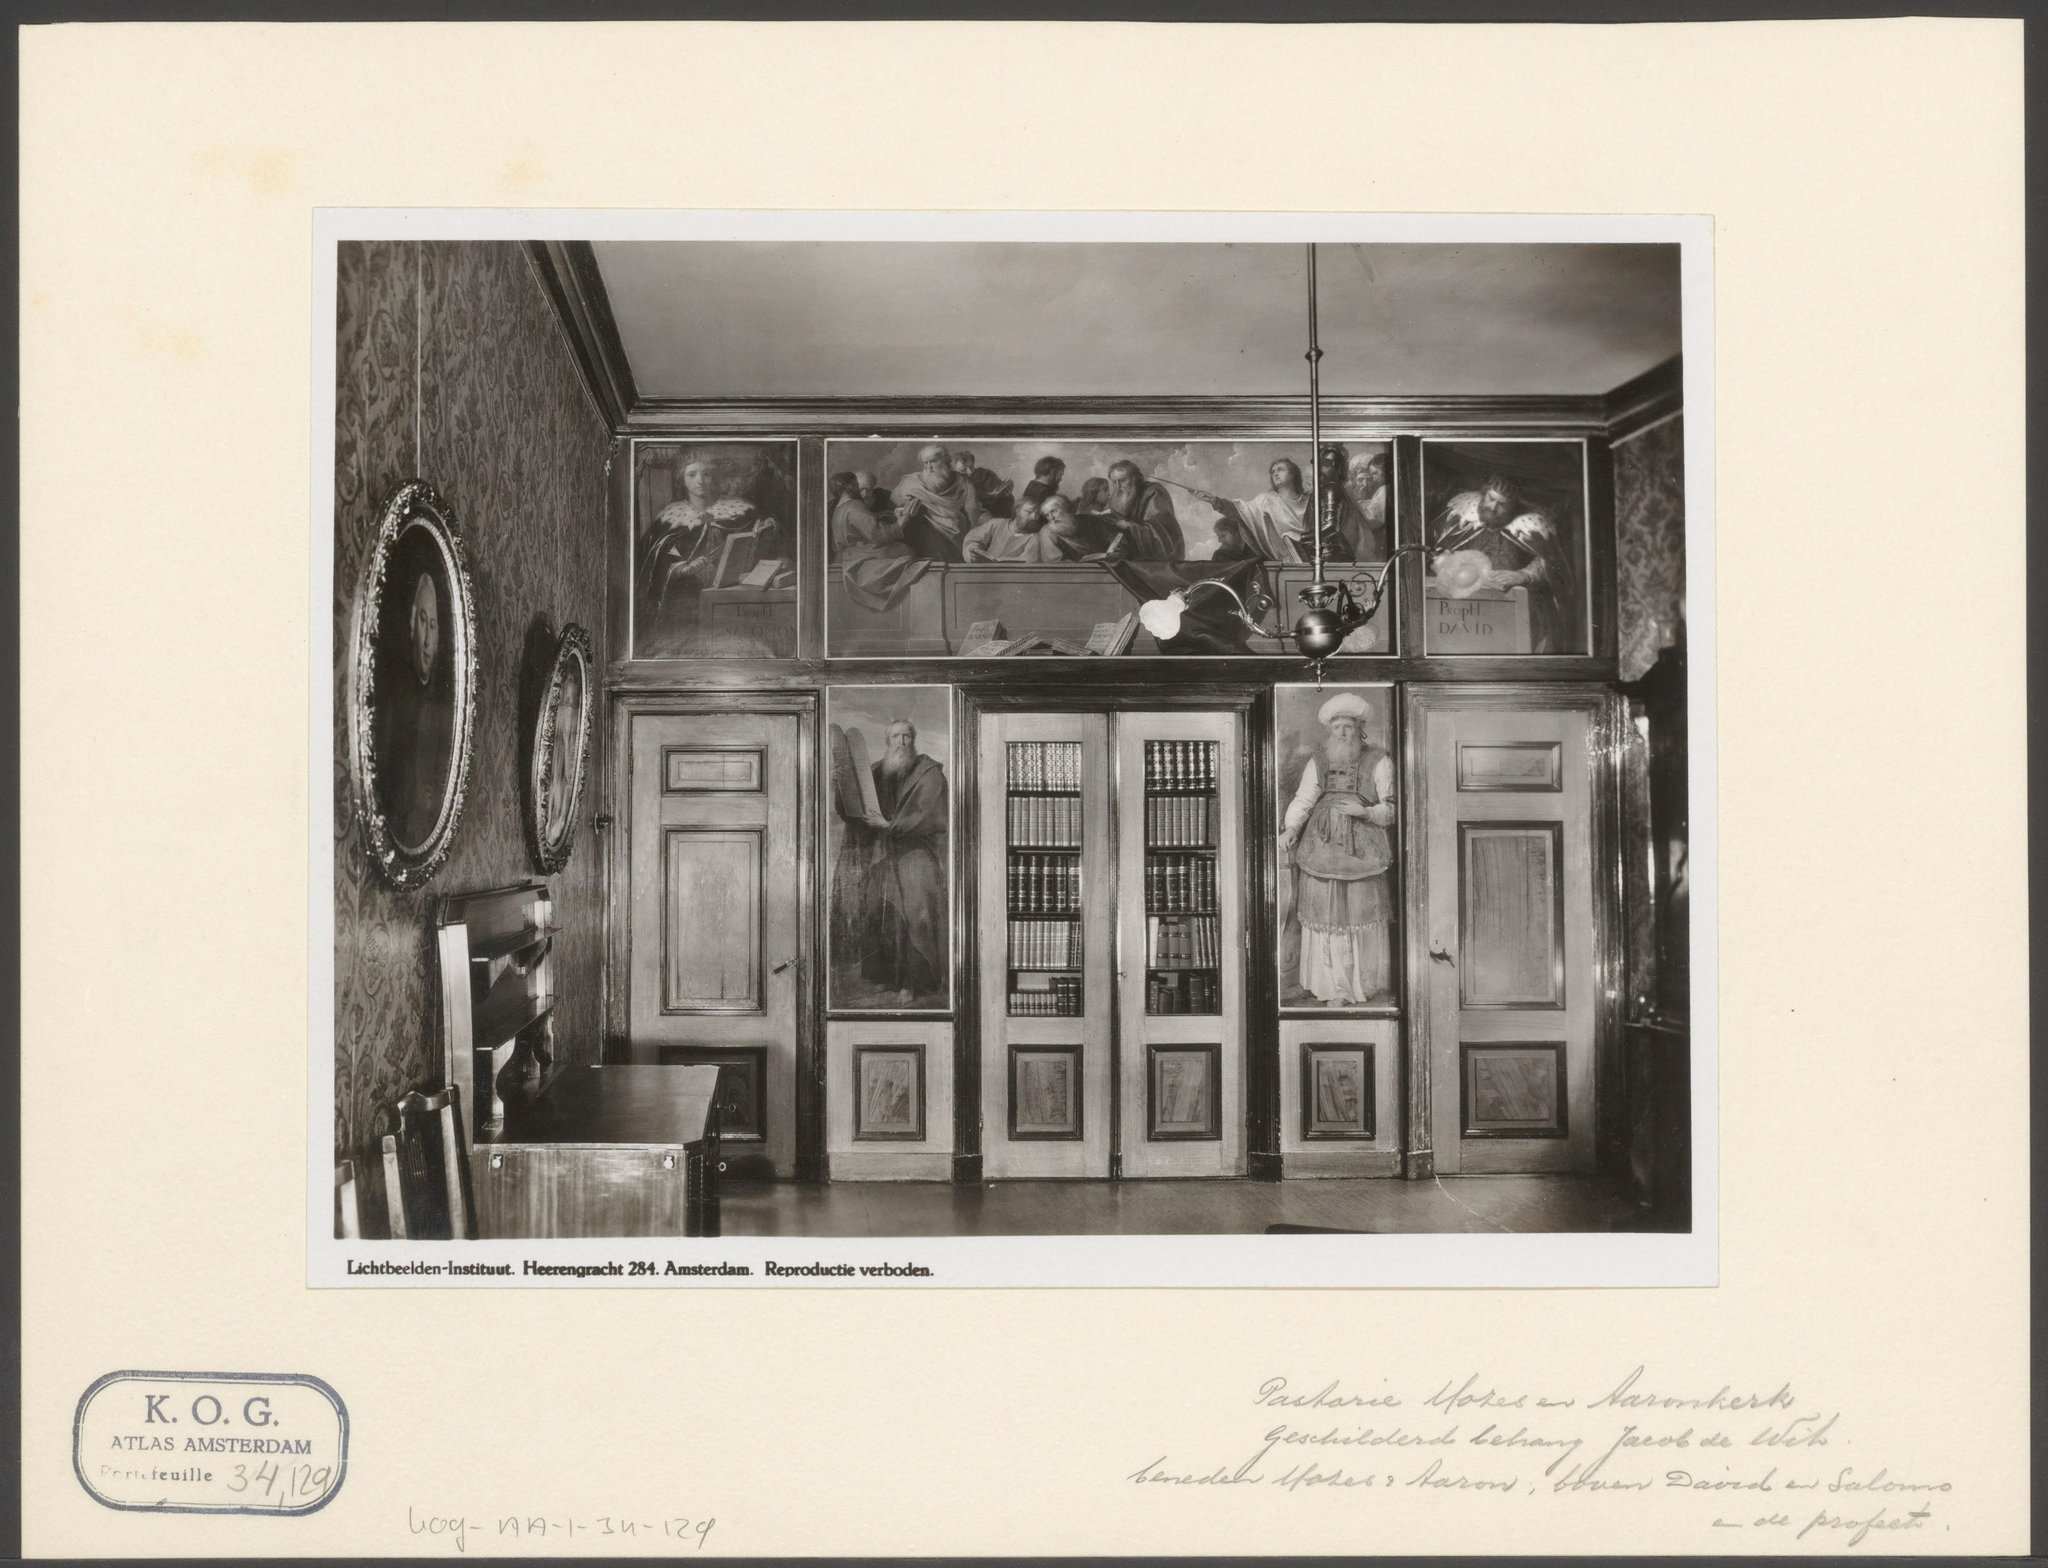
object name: photograph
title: Interieur van de pastorie van de Mozes en Aäronkerk te Amsterdam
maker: Anonymous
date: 1935-1960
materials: paper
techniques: gelatin silver print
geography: netherlands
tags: interior of the house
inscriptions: collector's mark: Lugt 1641b, inscription: ‘Lichtbeelden-Instituut. Heerengracht 284. Amsterdam. Reproductie verboden.’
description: Onderwerpsrubriek binnen de Atlas Amsterdam: Kerkwezen: R.K. Gemeenten: Begijnhof t/m Petrus en Paulus.